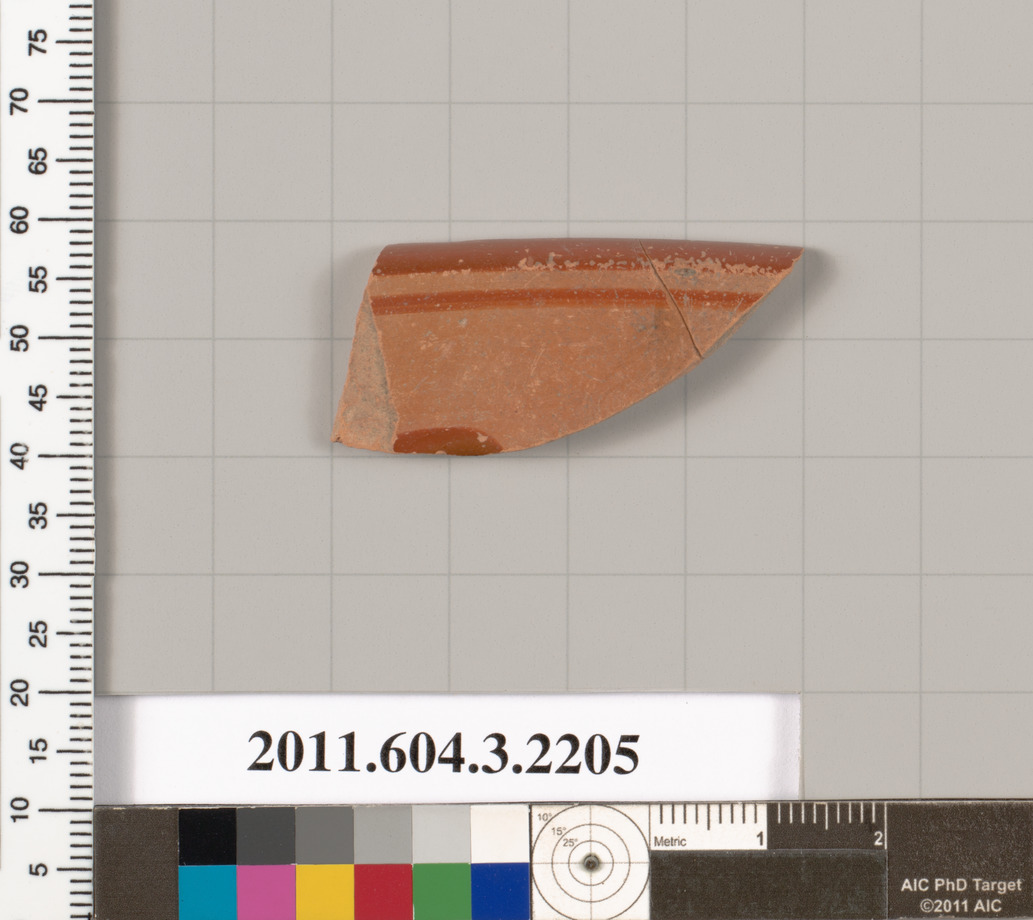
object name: kylix fragment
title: Terracotta rim fragment of a kylix (drinking cup)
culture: greek, attic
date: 600-401 BCE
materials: terracotta